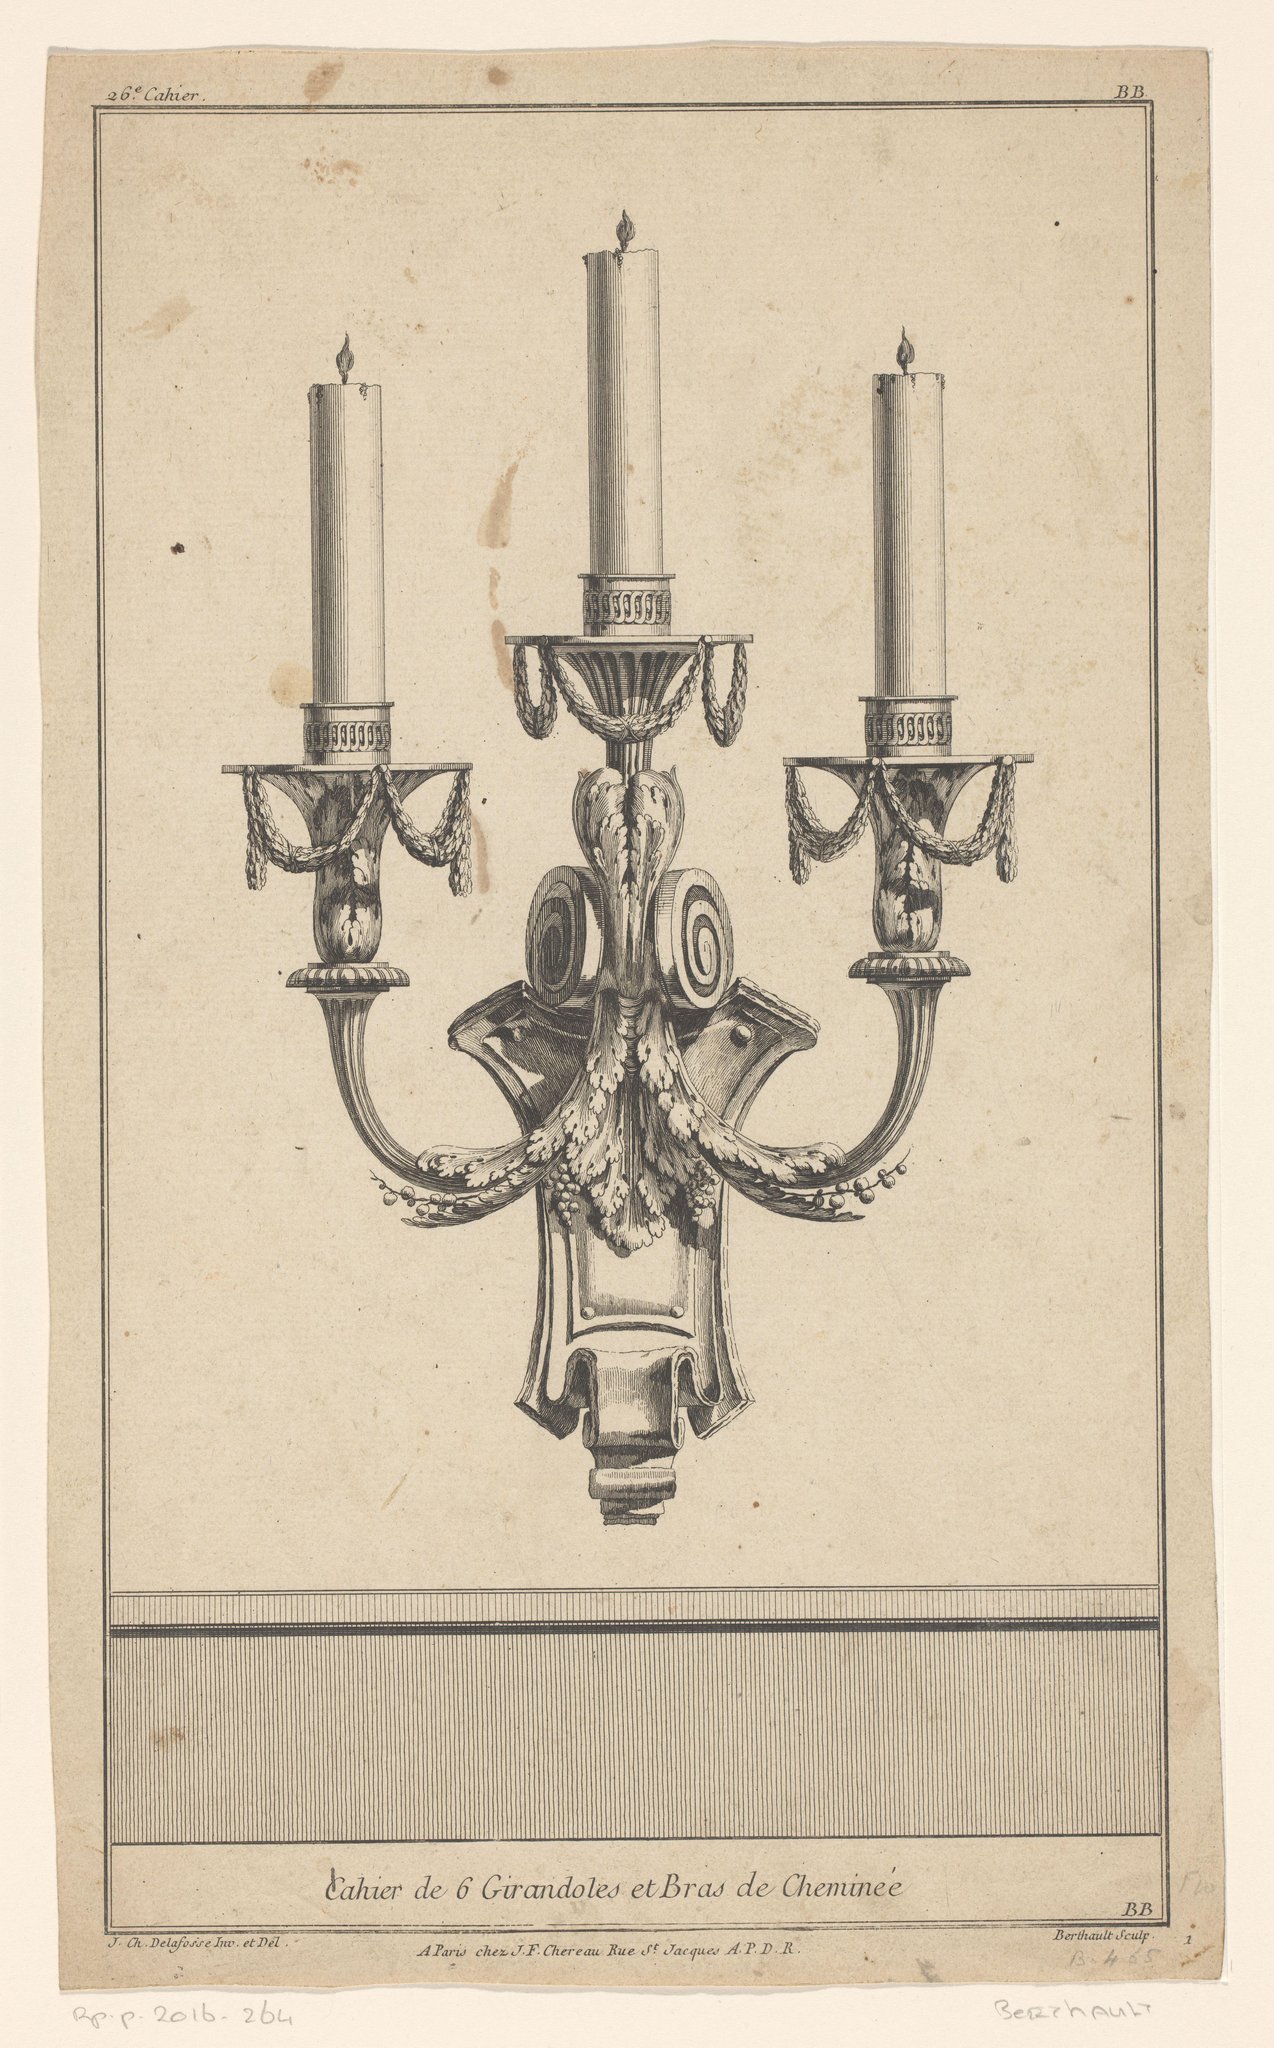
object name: titelprent, frontispice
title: Driearmige girandole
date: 1771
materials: paper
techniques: engraving, etching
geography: paris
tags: chandelier, candelabrum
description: Een geornamenteerde driearmige girandole.